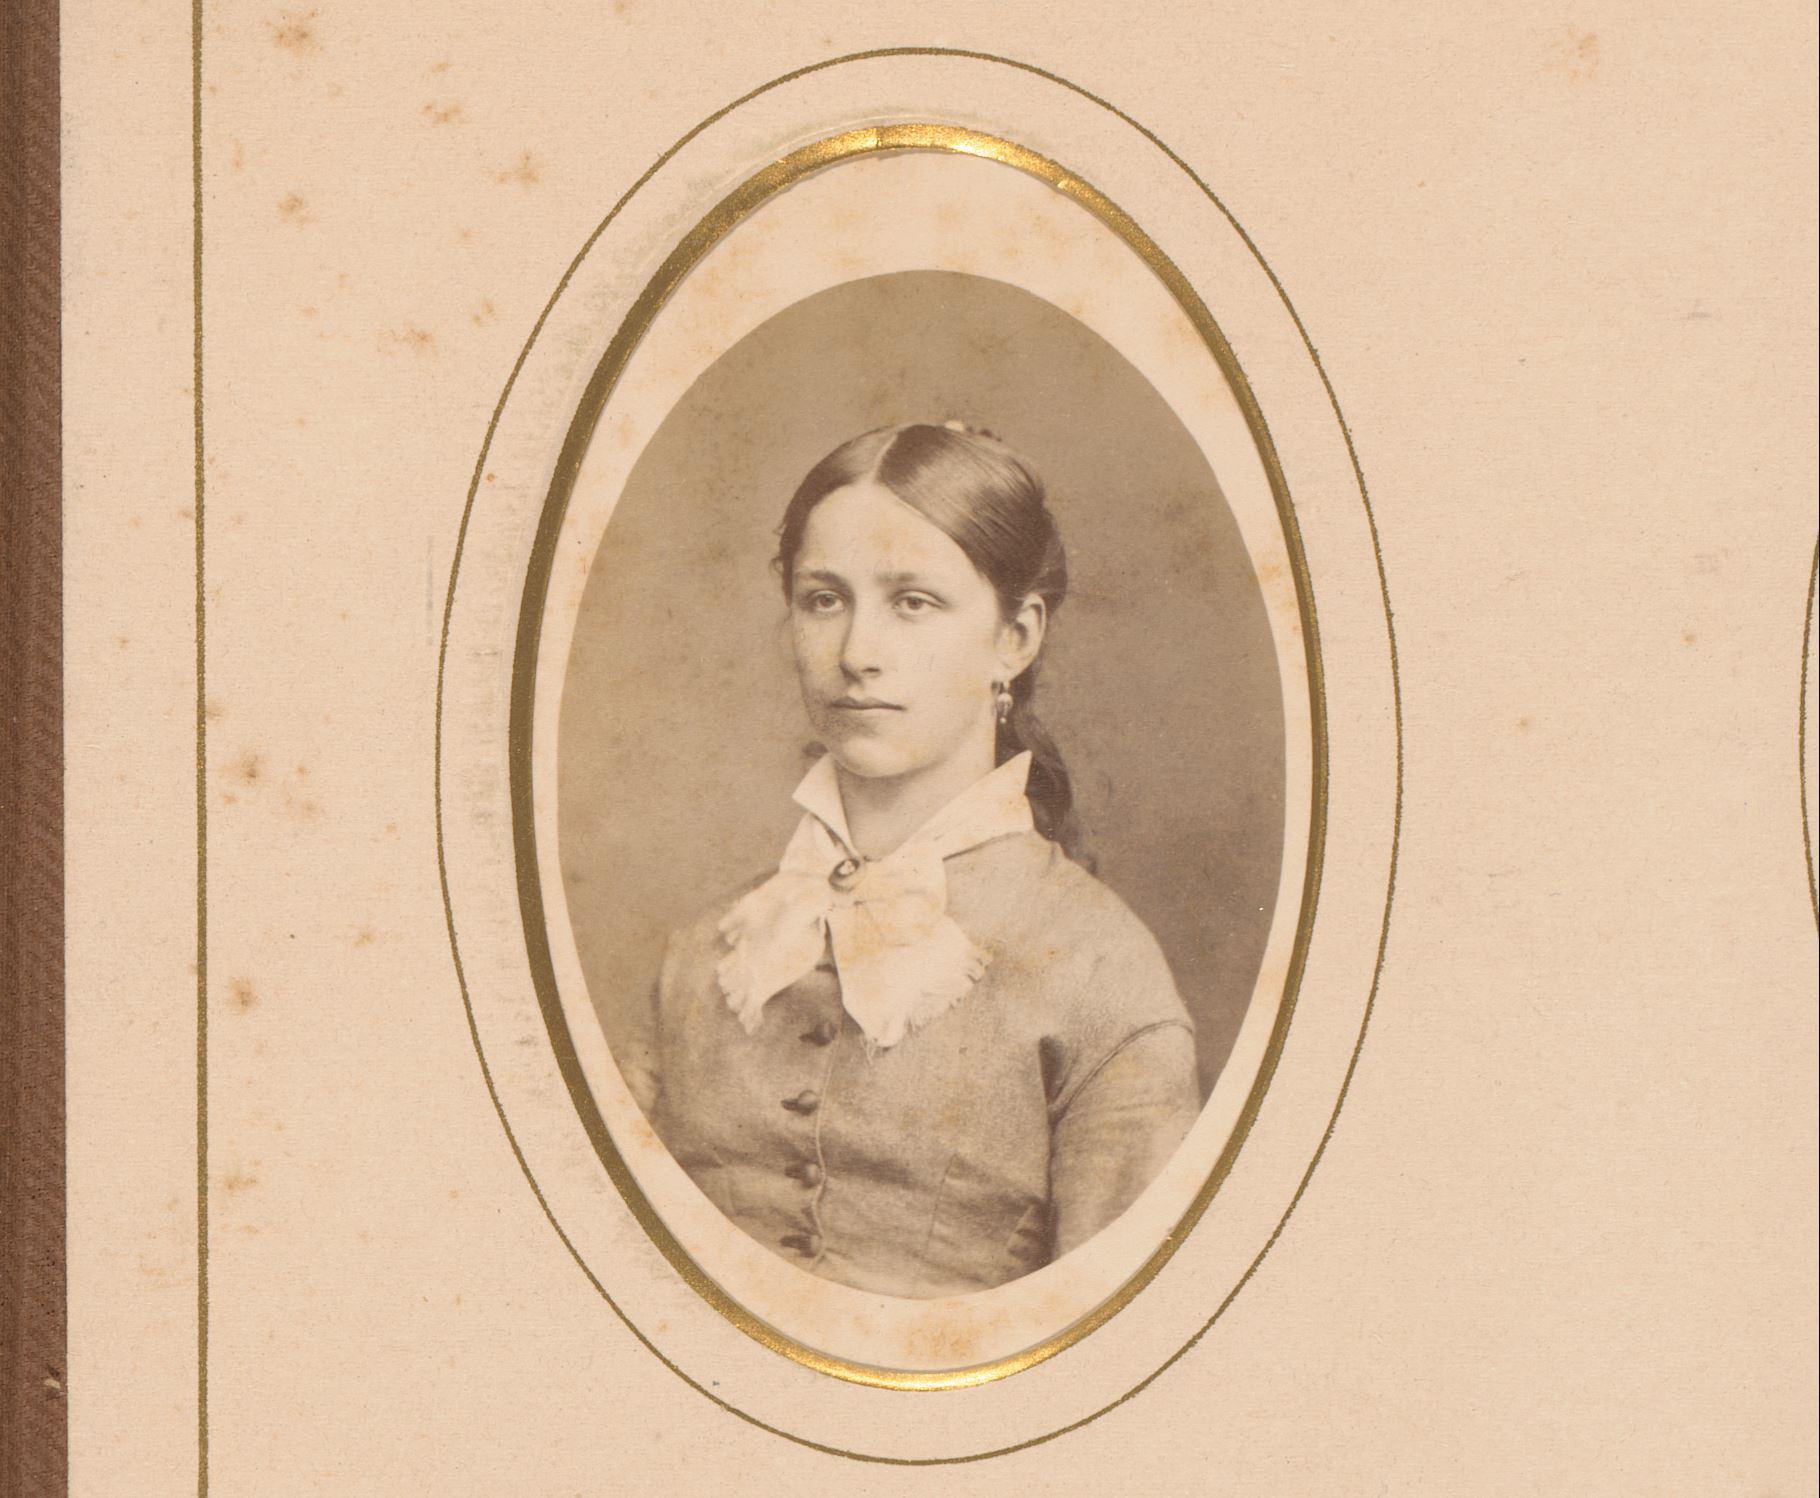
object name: photograph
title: Portret van een jonge vrouw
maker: george lodewijk mulder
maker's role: fotograaf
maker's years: 1841-1920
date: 1859-1898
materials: cardboard, photographic support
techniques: albumen print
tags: adolescent, young woman, maiden, historical persons - bb - woman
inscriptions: inscription: ‘G. L. Mulder/ van Wijckskade H. 326/ Utrecht.’